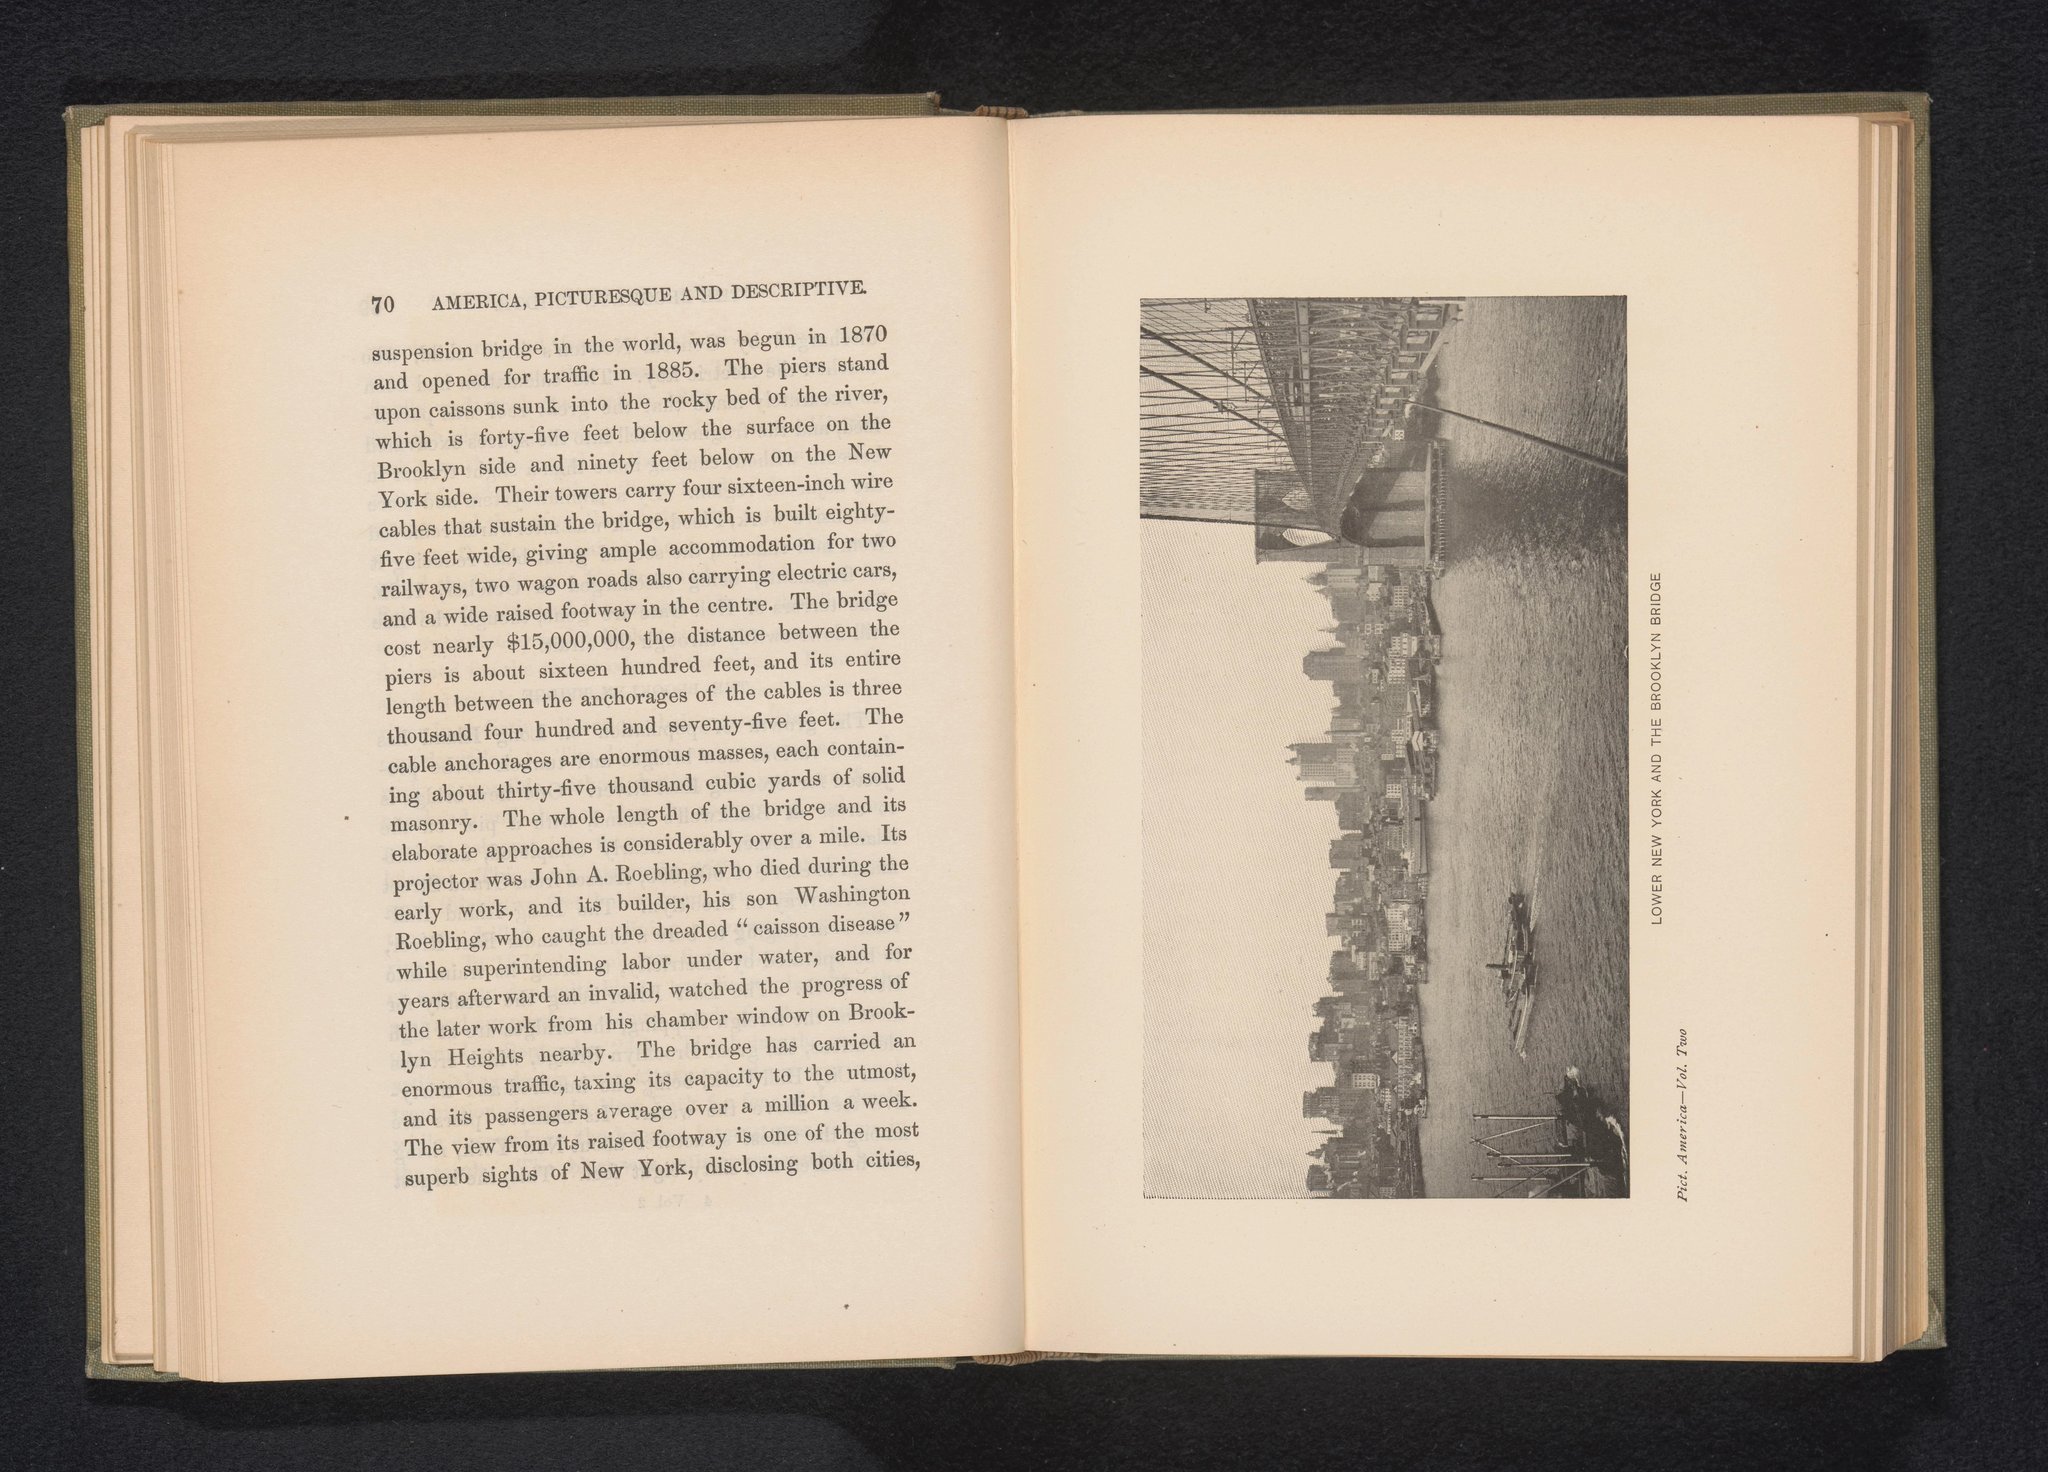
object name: photomechanical print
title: Lower New York and the Brooklyn Bridge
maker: Anonymous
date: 1890-1900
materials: paper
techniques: autotype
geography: brooklyn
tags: city-view in general; 'veduta', bridge, manhattan